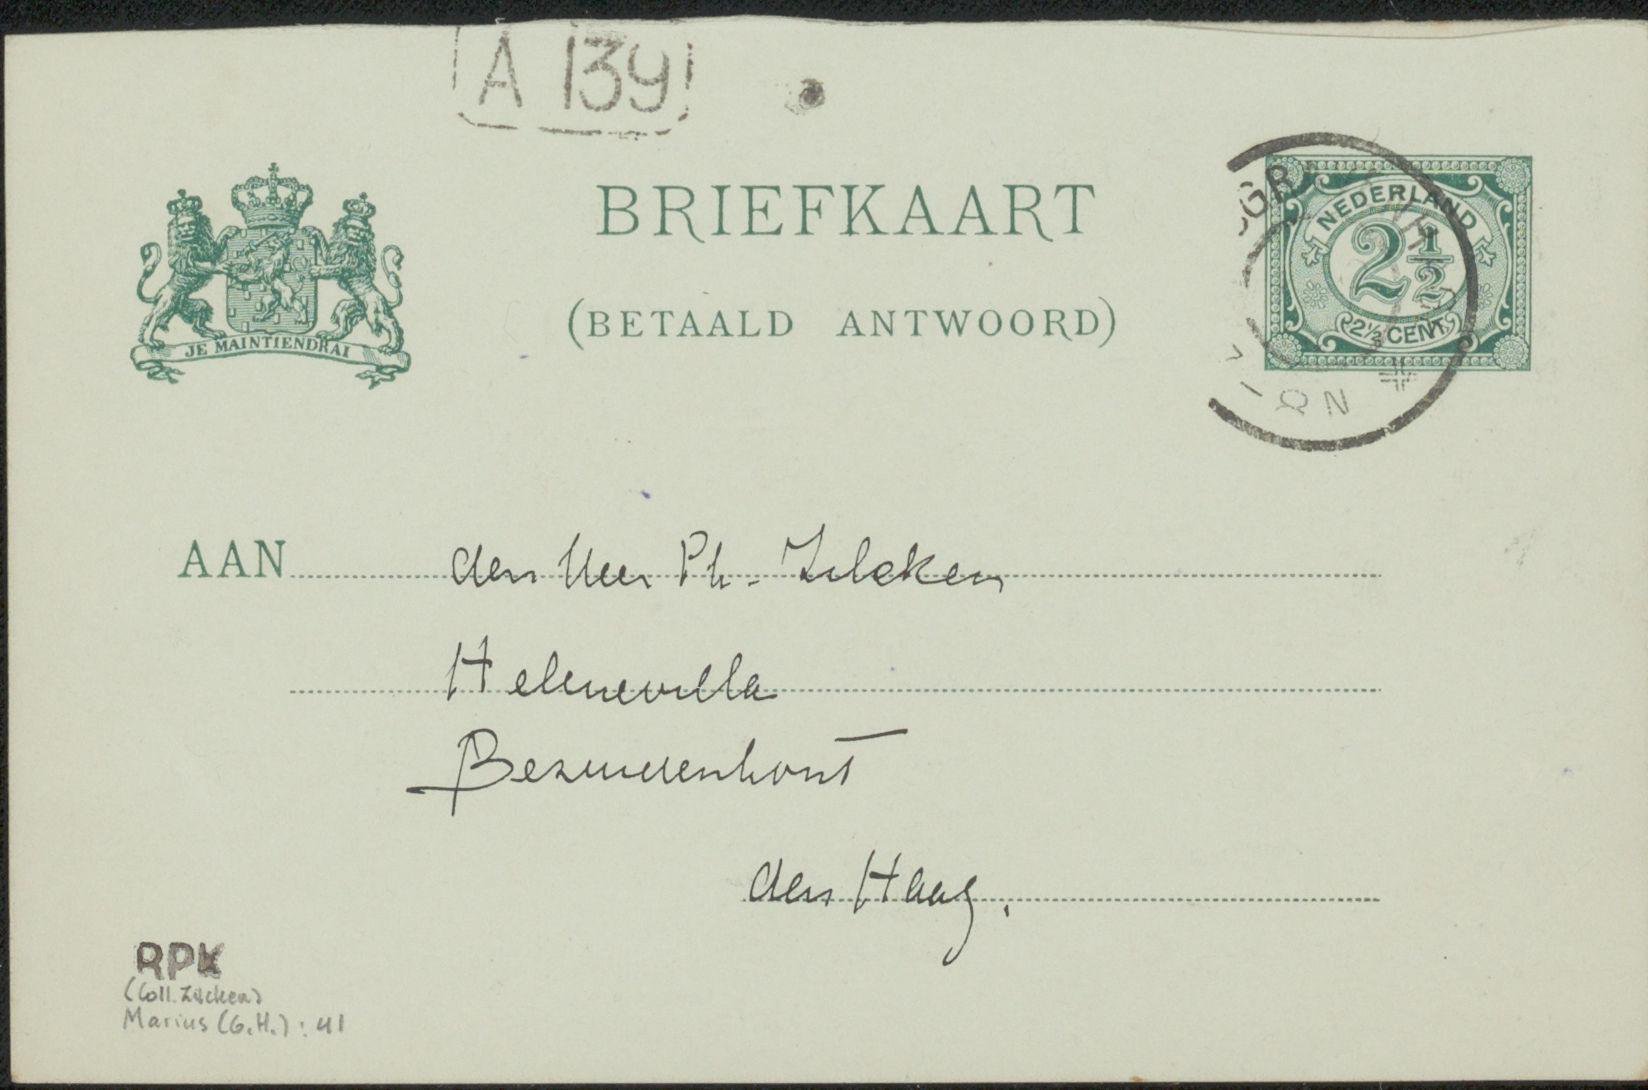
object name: postcard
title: Briefkaart aan Philip Zilcken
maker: grada hermina marius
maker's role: painter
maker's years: 1854-1919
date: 1904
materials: cardboard, ink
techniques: pen, writing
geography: the hague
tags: utrecht, print maker, albert neuhuys (1844-1914), draughtsman, philip zilcken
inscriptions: collector's mark: ‘RPK’